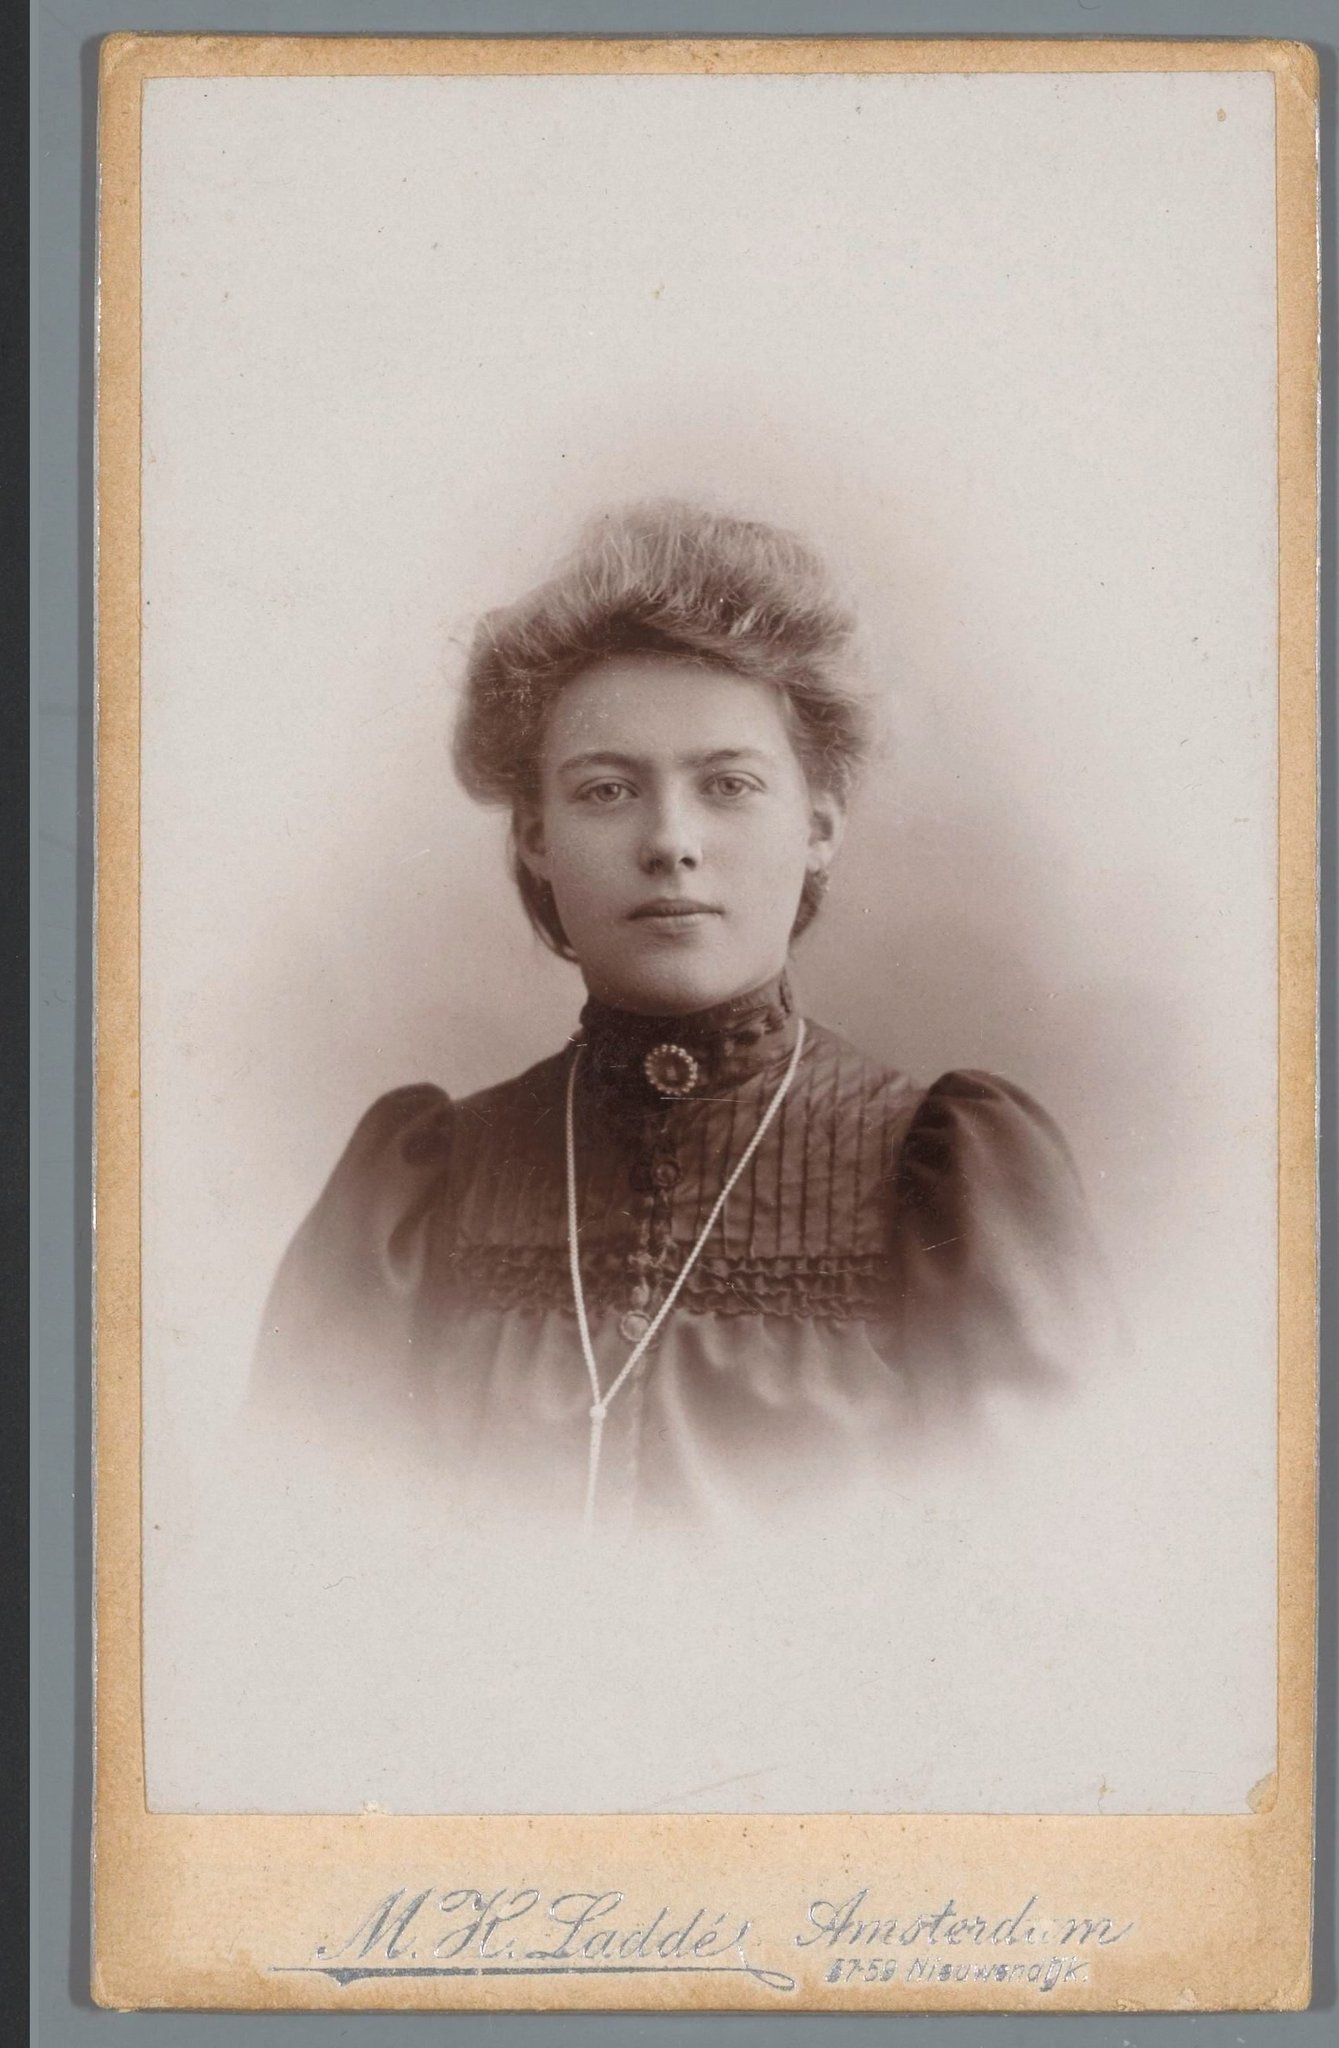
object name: carte de visite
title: Portret van een onbekende vrouw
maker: machiel hendricus laddé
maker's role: fotograaf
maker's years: 1866-1932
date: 1892-1906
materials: cardboard, photographic support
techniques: collodion silver print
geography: amsterdam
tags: historical persons - bb - woman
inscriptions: address: ‘M. H. Laddé/ Amsterdam/ 57-59 Nieuwendijk.’